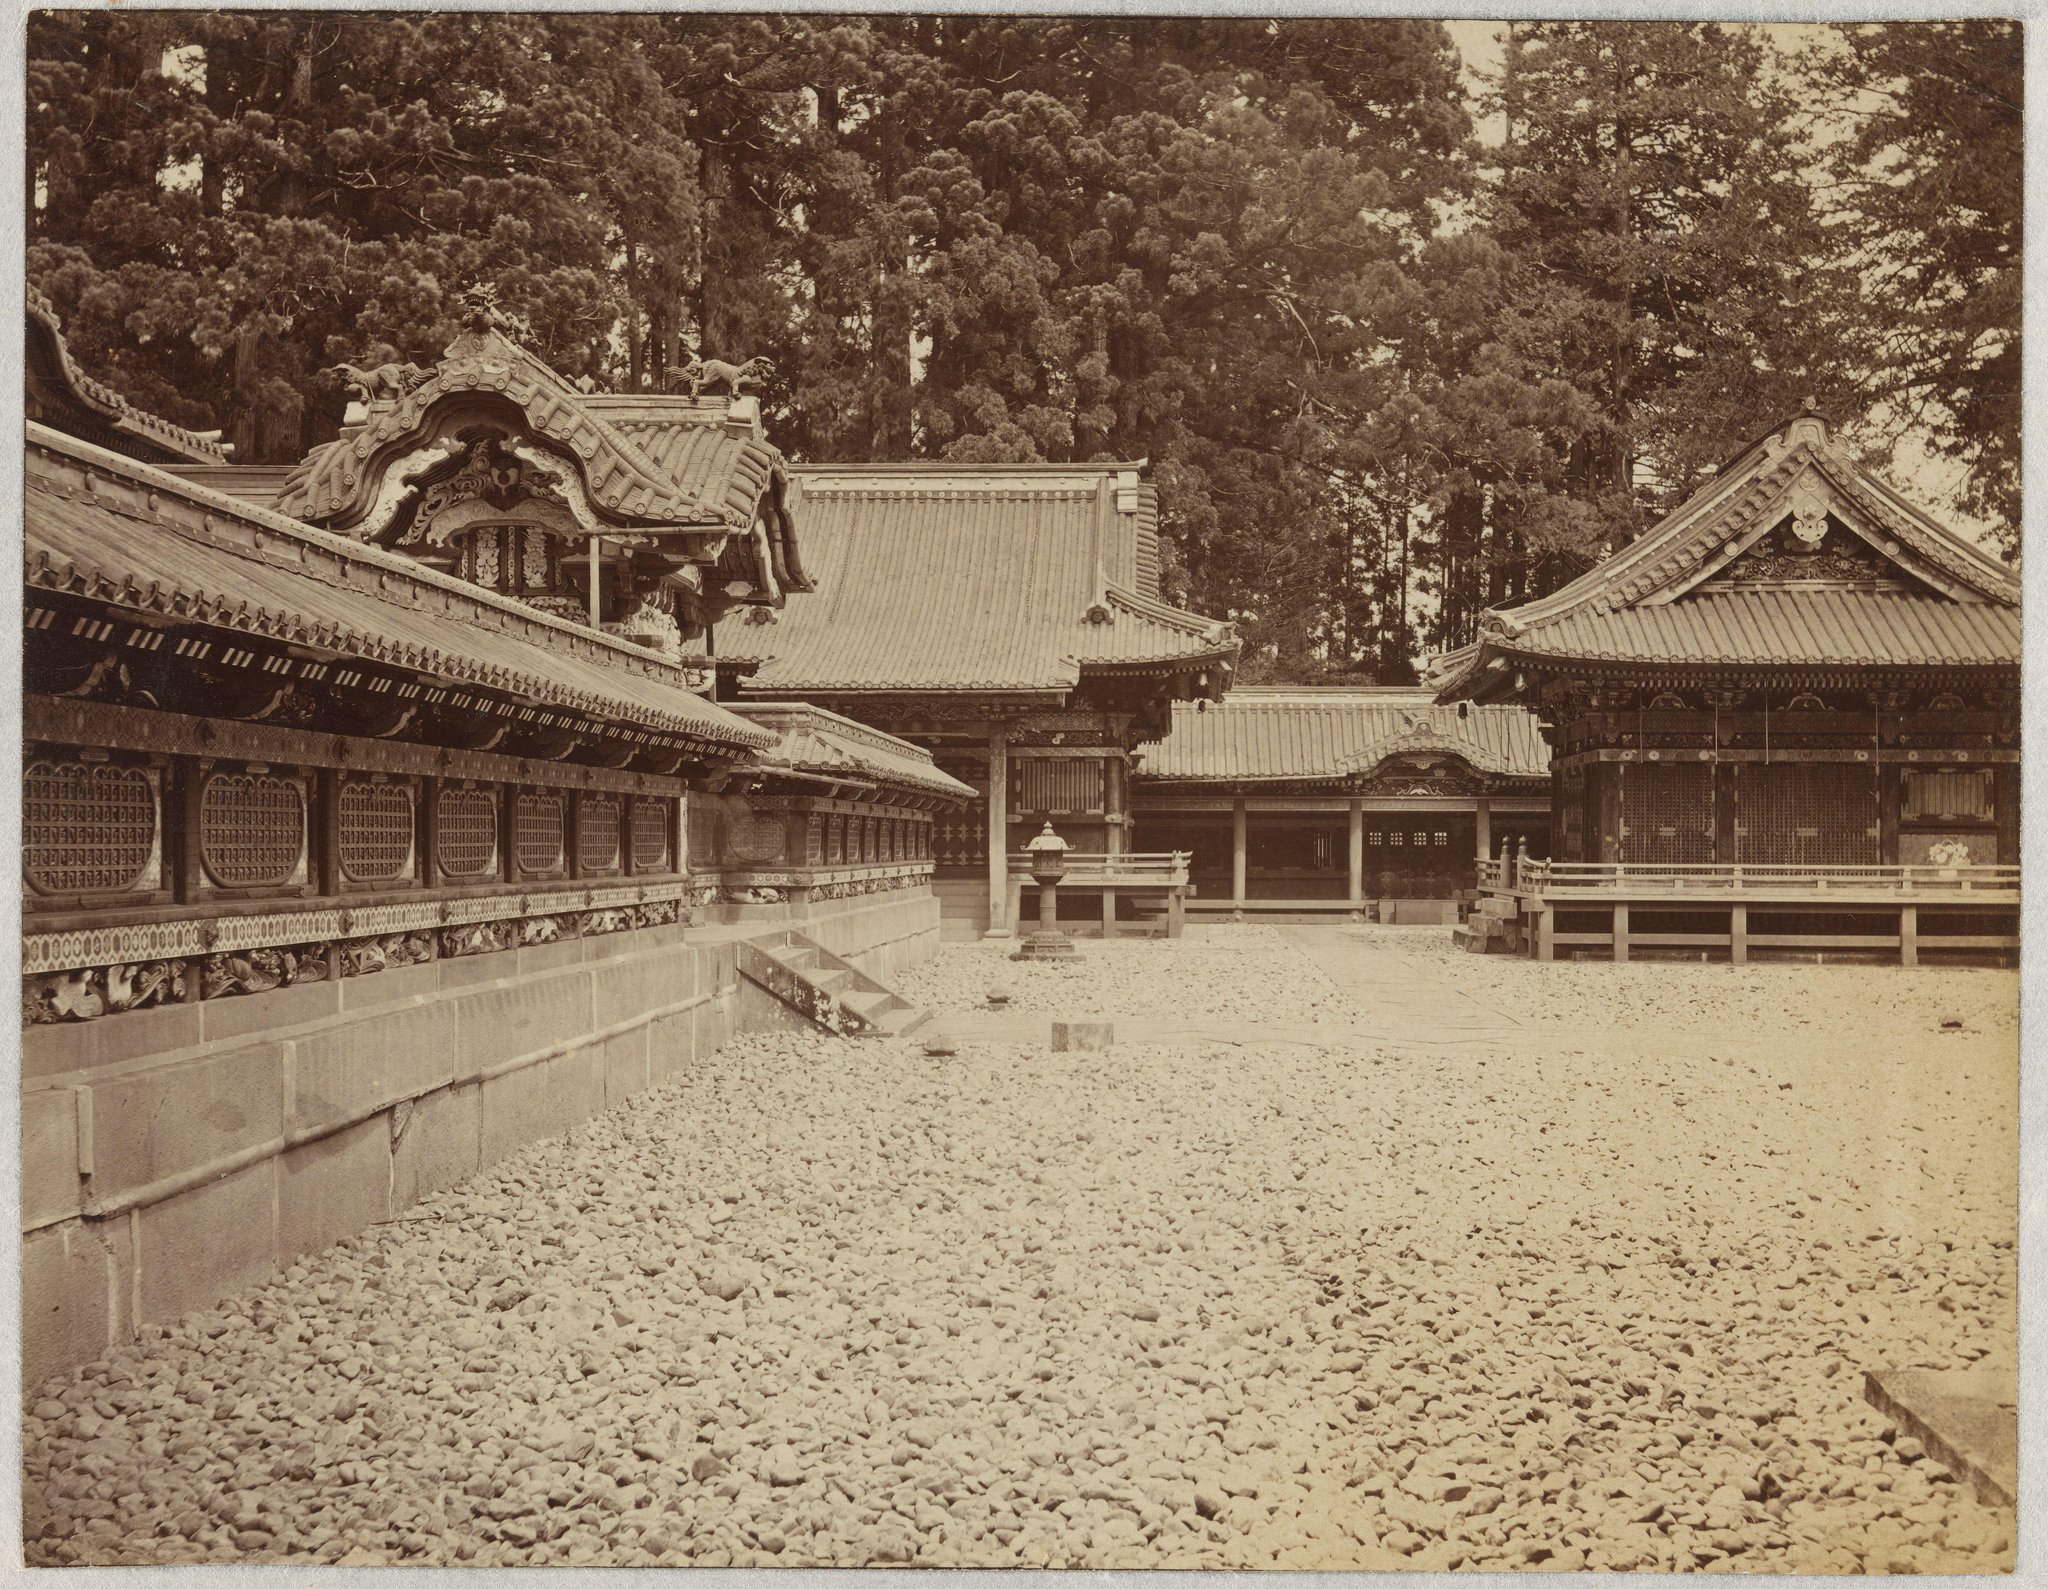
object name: photograph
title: Niko, tempel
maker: Anonymous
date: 1865-1870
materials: paper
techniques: albumen print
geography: japan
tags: japan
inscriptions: inscription: ‘[tekst in Japans]’, number: ‘BD 223’, number: ‘E6’, number: ‘5’, inscription: ‘NIKO’